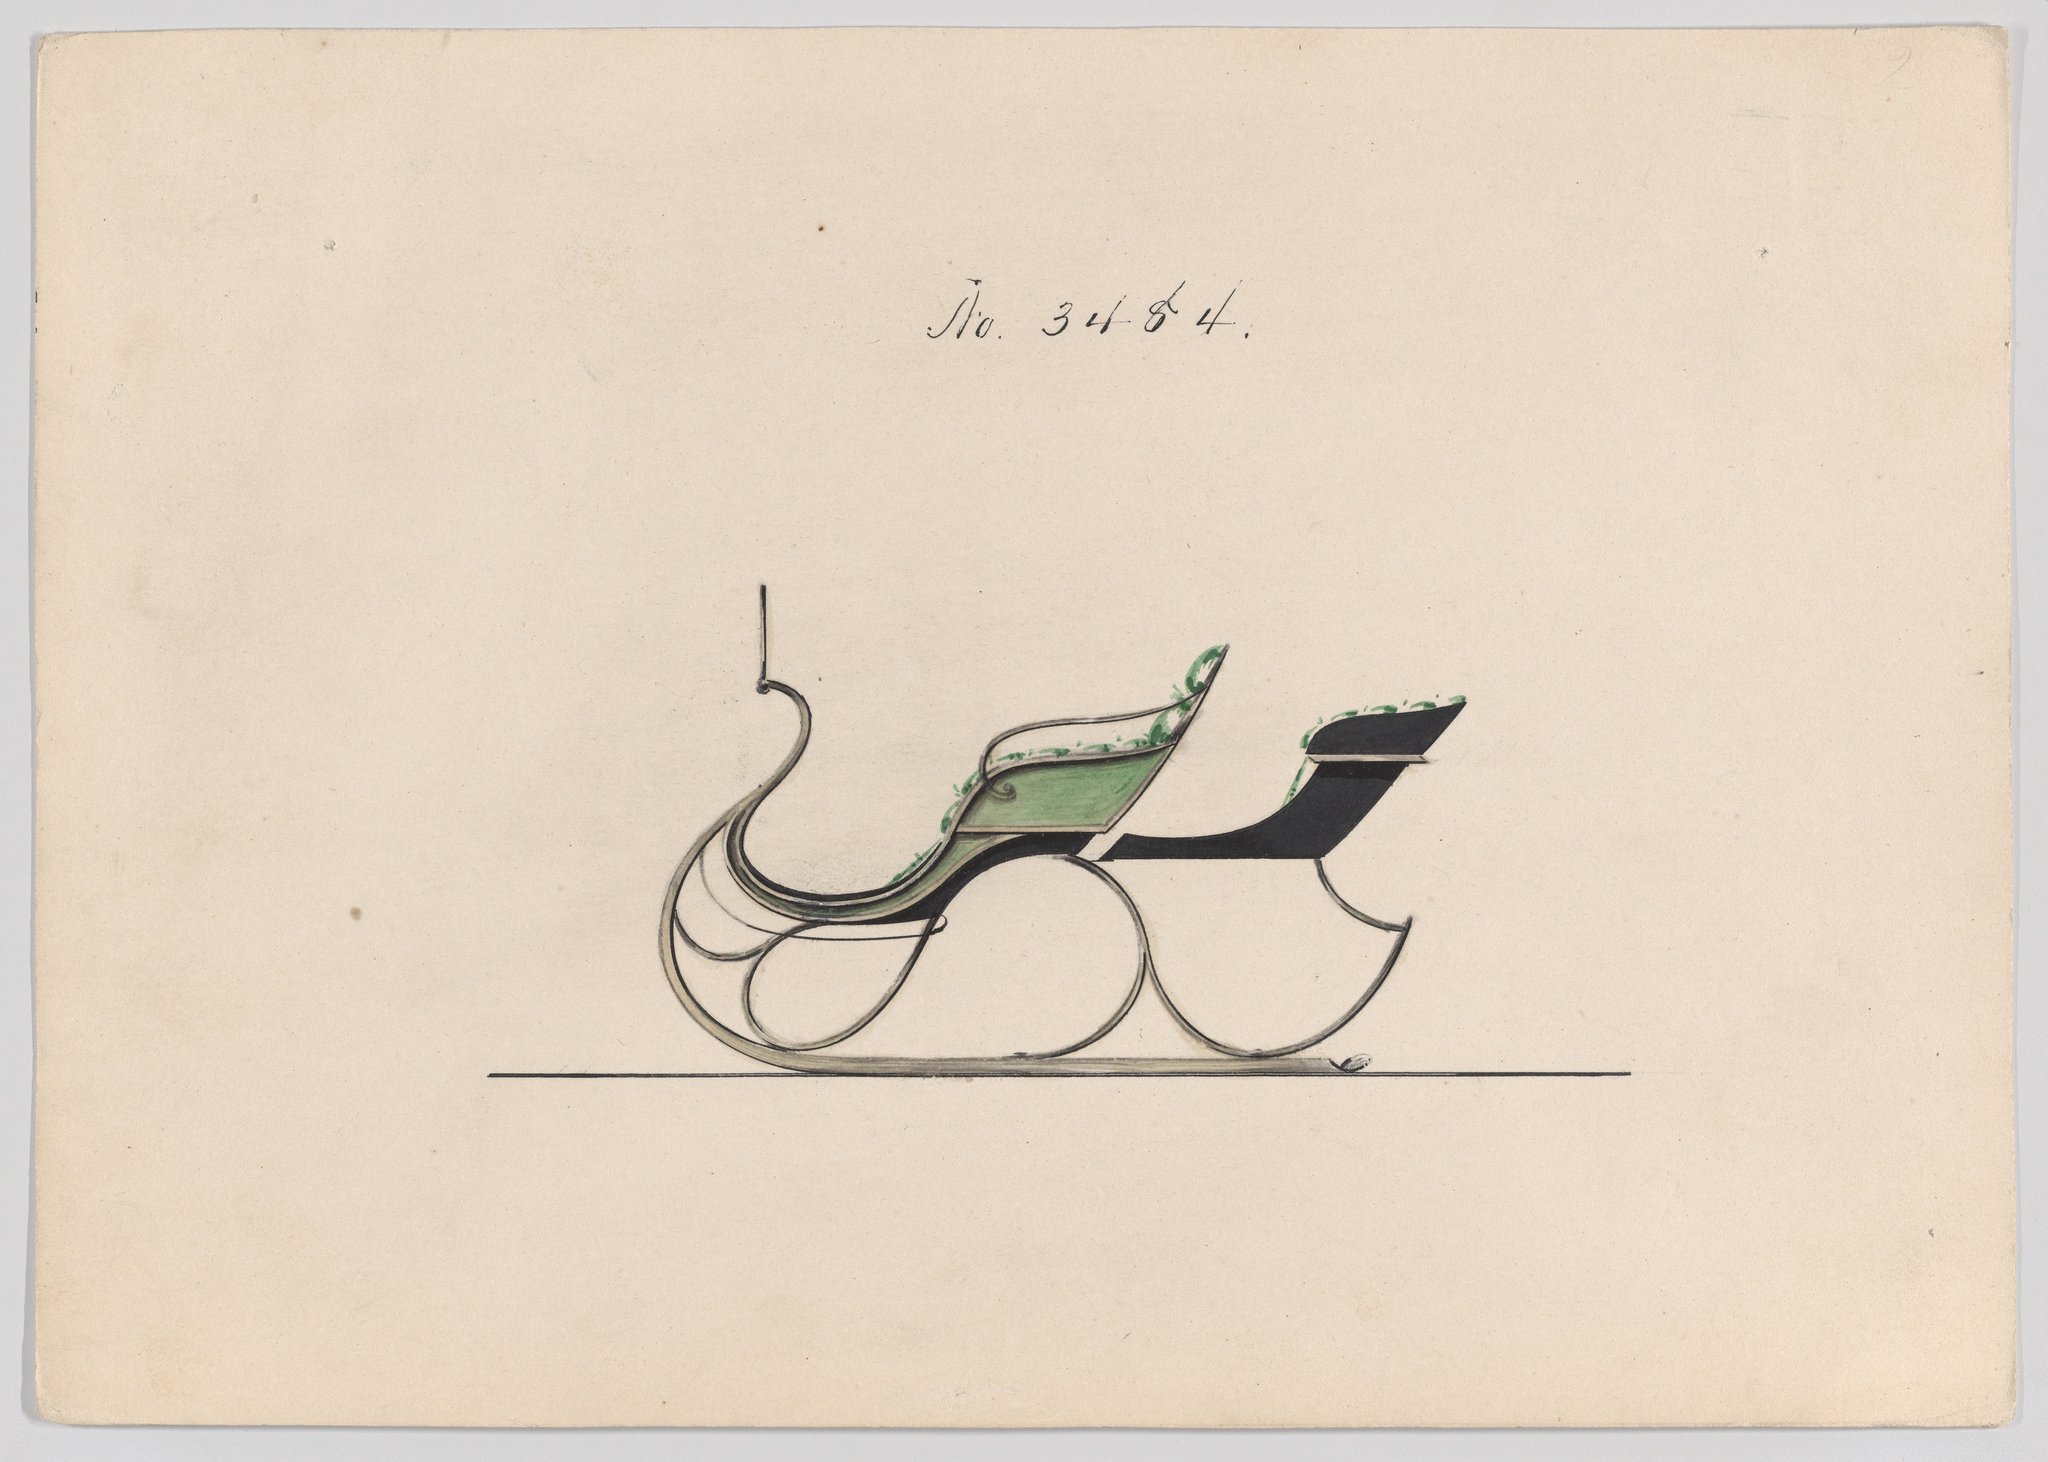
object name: drawing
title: Sleigh with Rumble Seat # 3484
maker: brewster & co.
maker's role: manufacturer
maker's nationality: american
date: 1879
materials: gouache, gum arabic, watercolor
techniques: pen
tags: sleighs